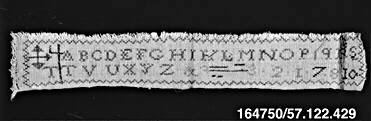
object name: sampler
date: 1801-1900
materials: cotton, linen